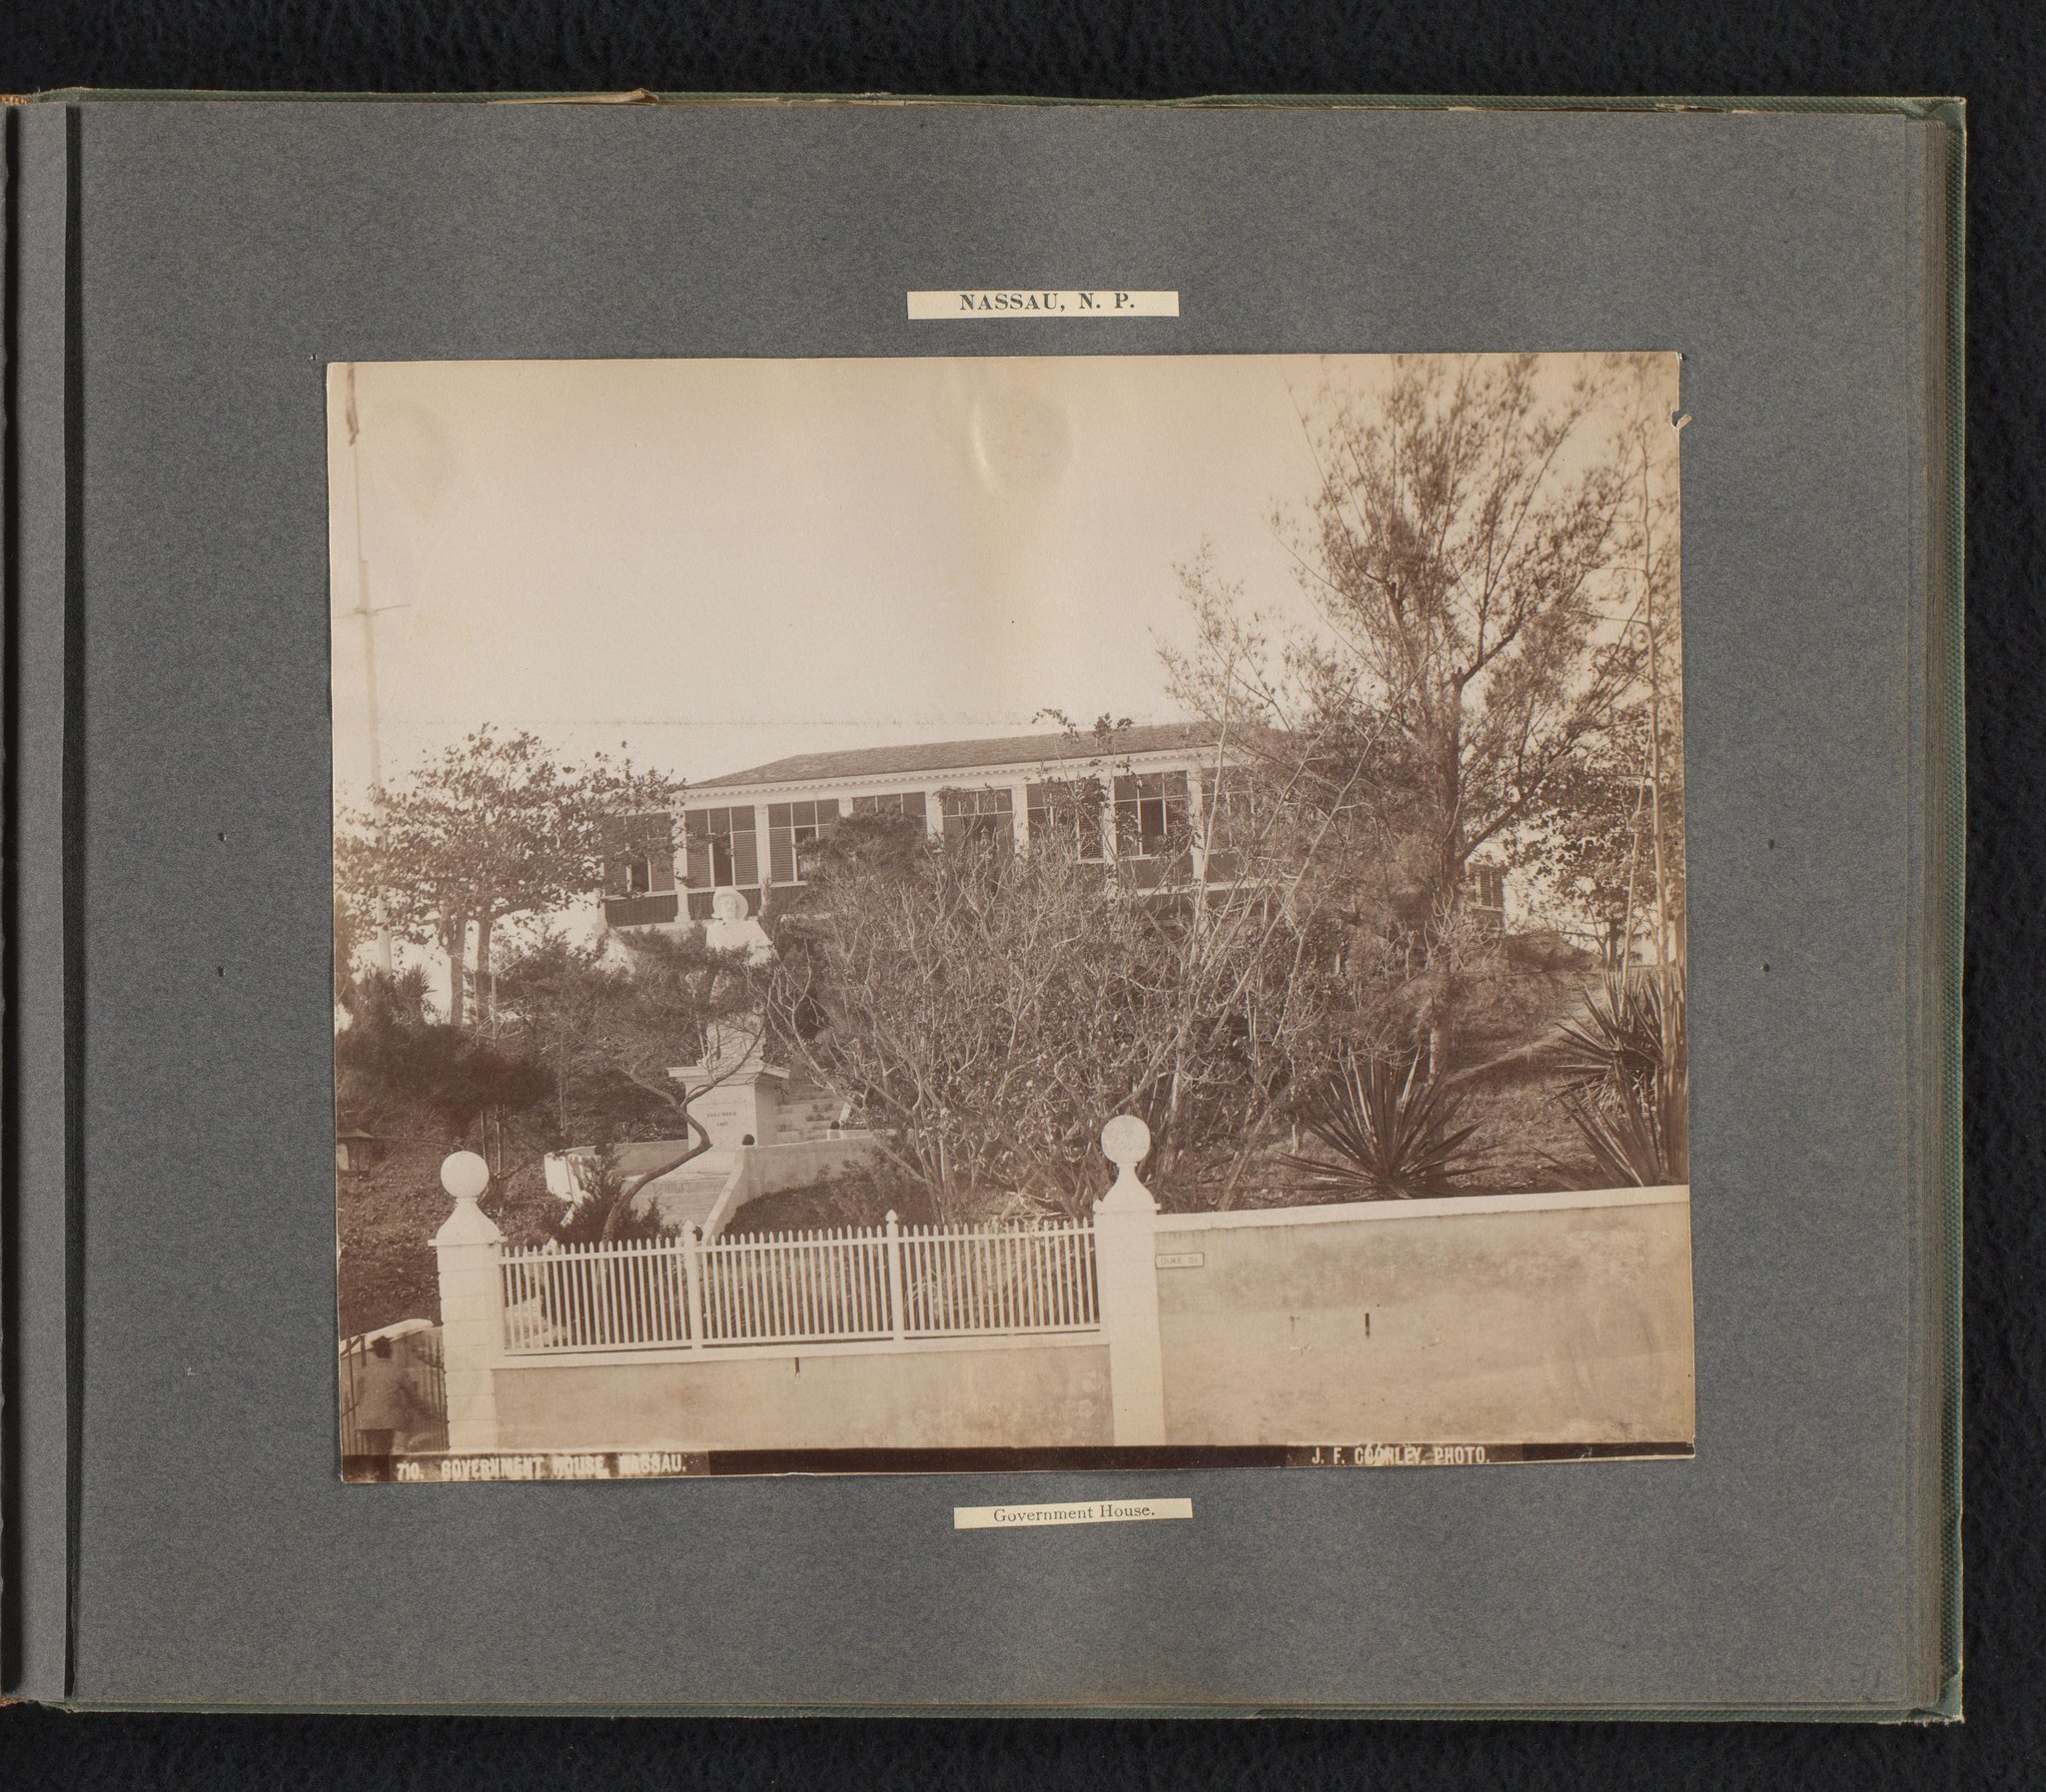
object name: photograph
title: Government House, Nassau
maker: jacob frank coonley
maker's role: fotograaf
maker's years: 1832-1915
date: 1889-1895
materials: paper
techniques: albumen print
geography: nassau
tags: exterior ~ representation of a building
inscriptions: number: ‘710.’